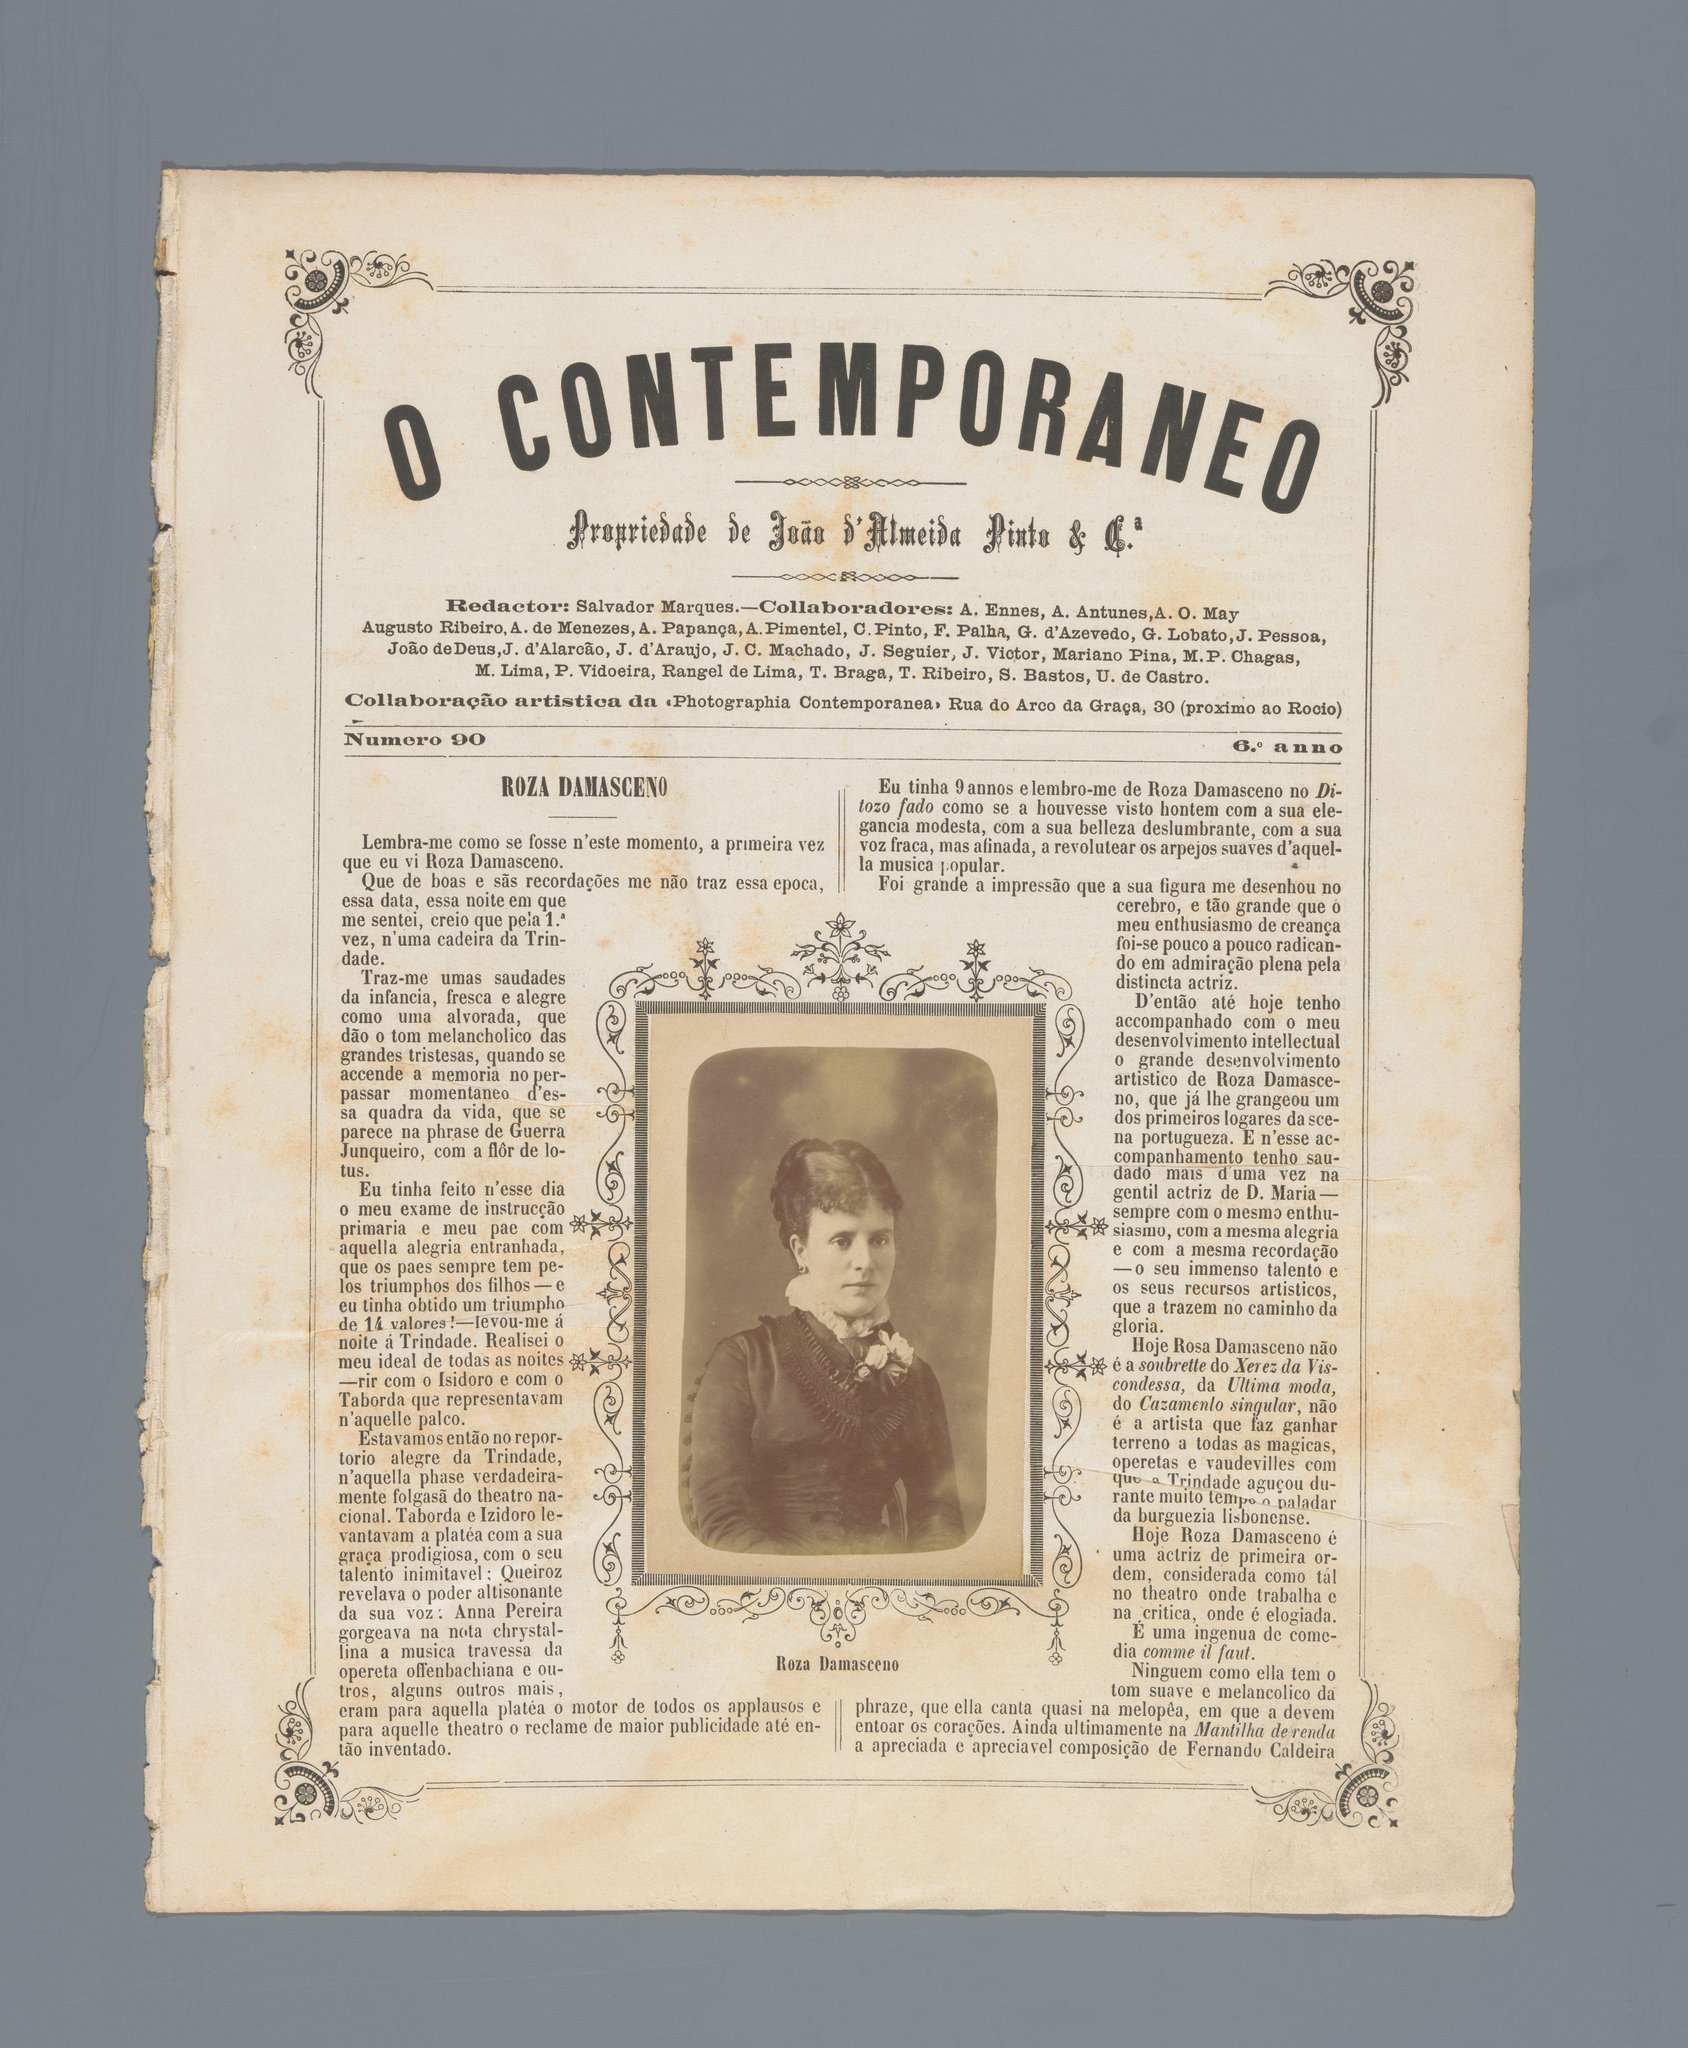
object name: magazine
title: O contemporaneo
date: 1875-1880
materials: paper, photographic support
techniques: albumen print, printing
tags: historical persons - bb - woman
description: Op de voorpagina bevindt zich een portret van Roza Damasceno.